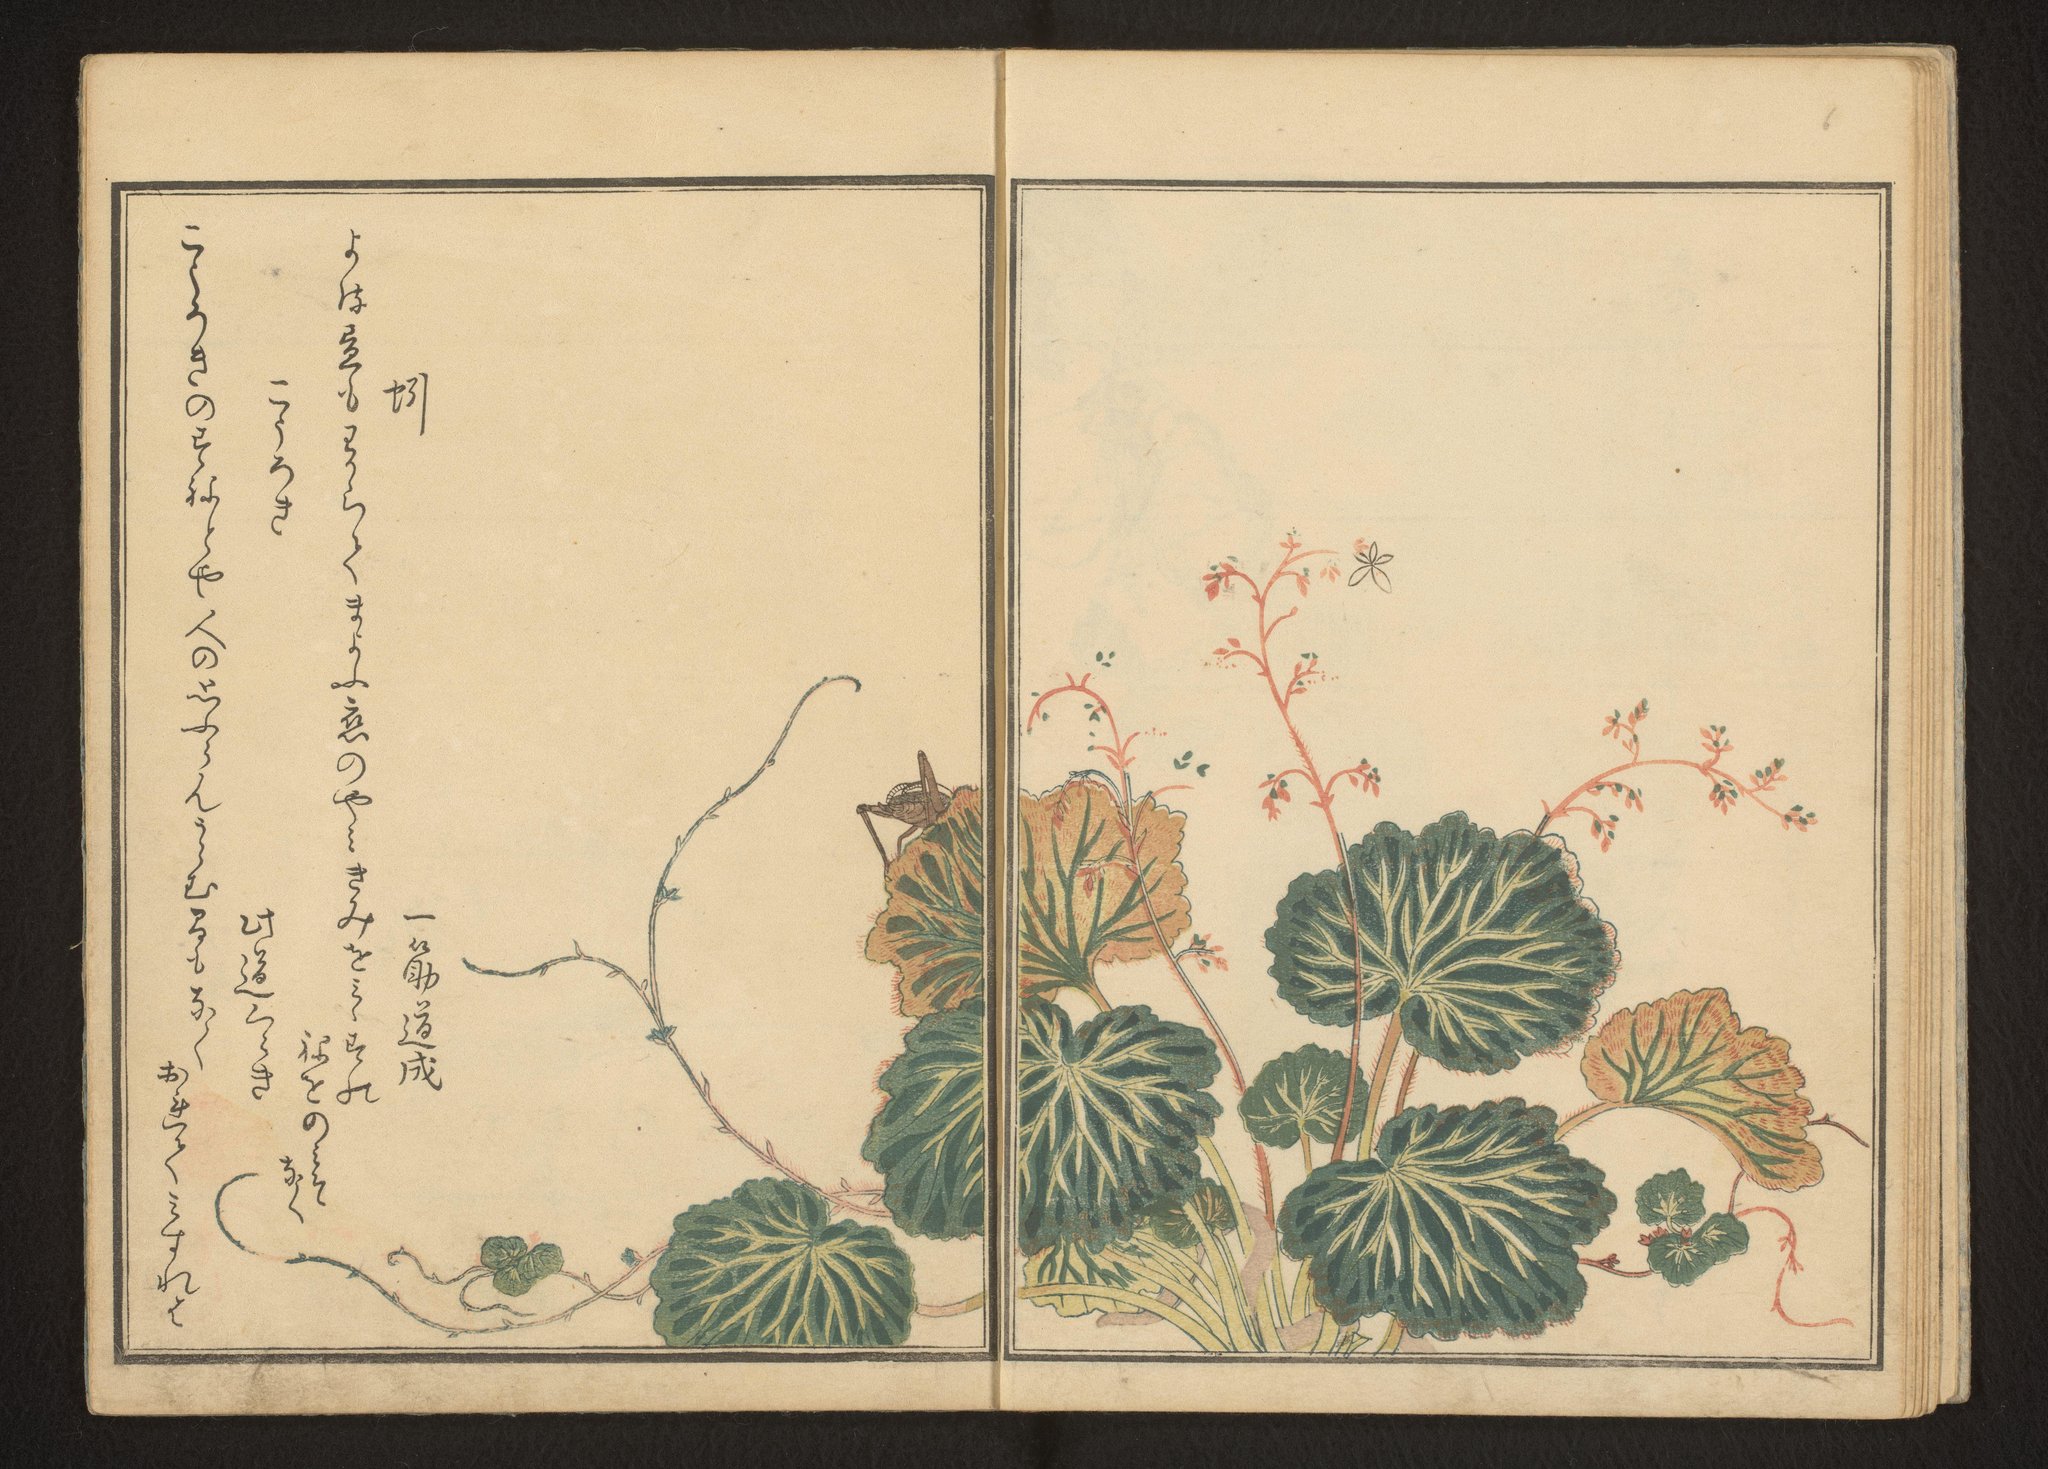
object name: page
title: Earthworm and black cricket on creeping saxifrage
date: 1788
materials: paper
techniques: woodcut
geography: edo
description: Pagina 16b en 17a in deel twee van het Insectenboek van Utamaro.